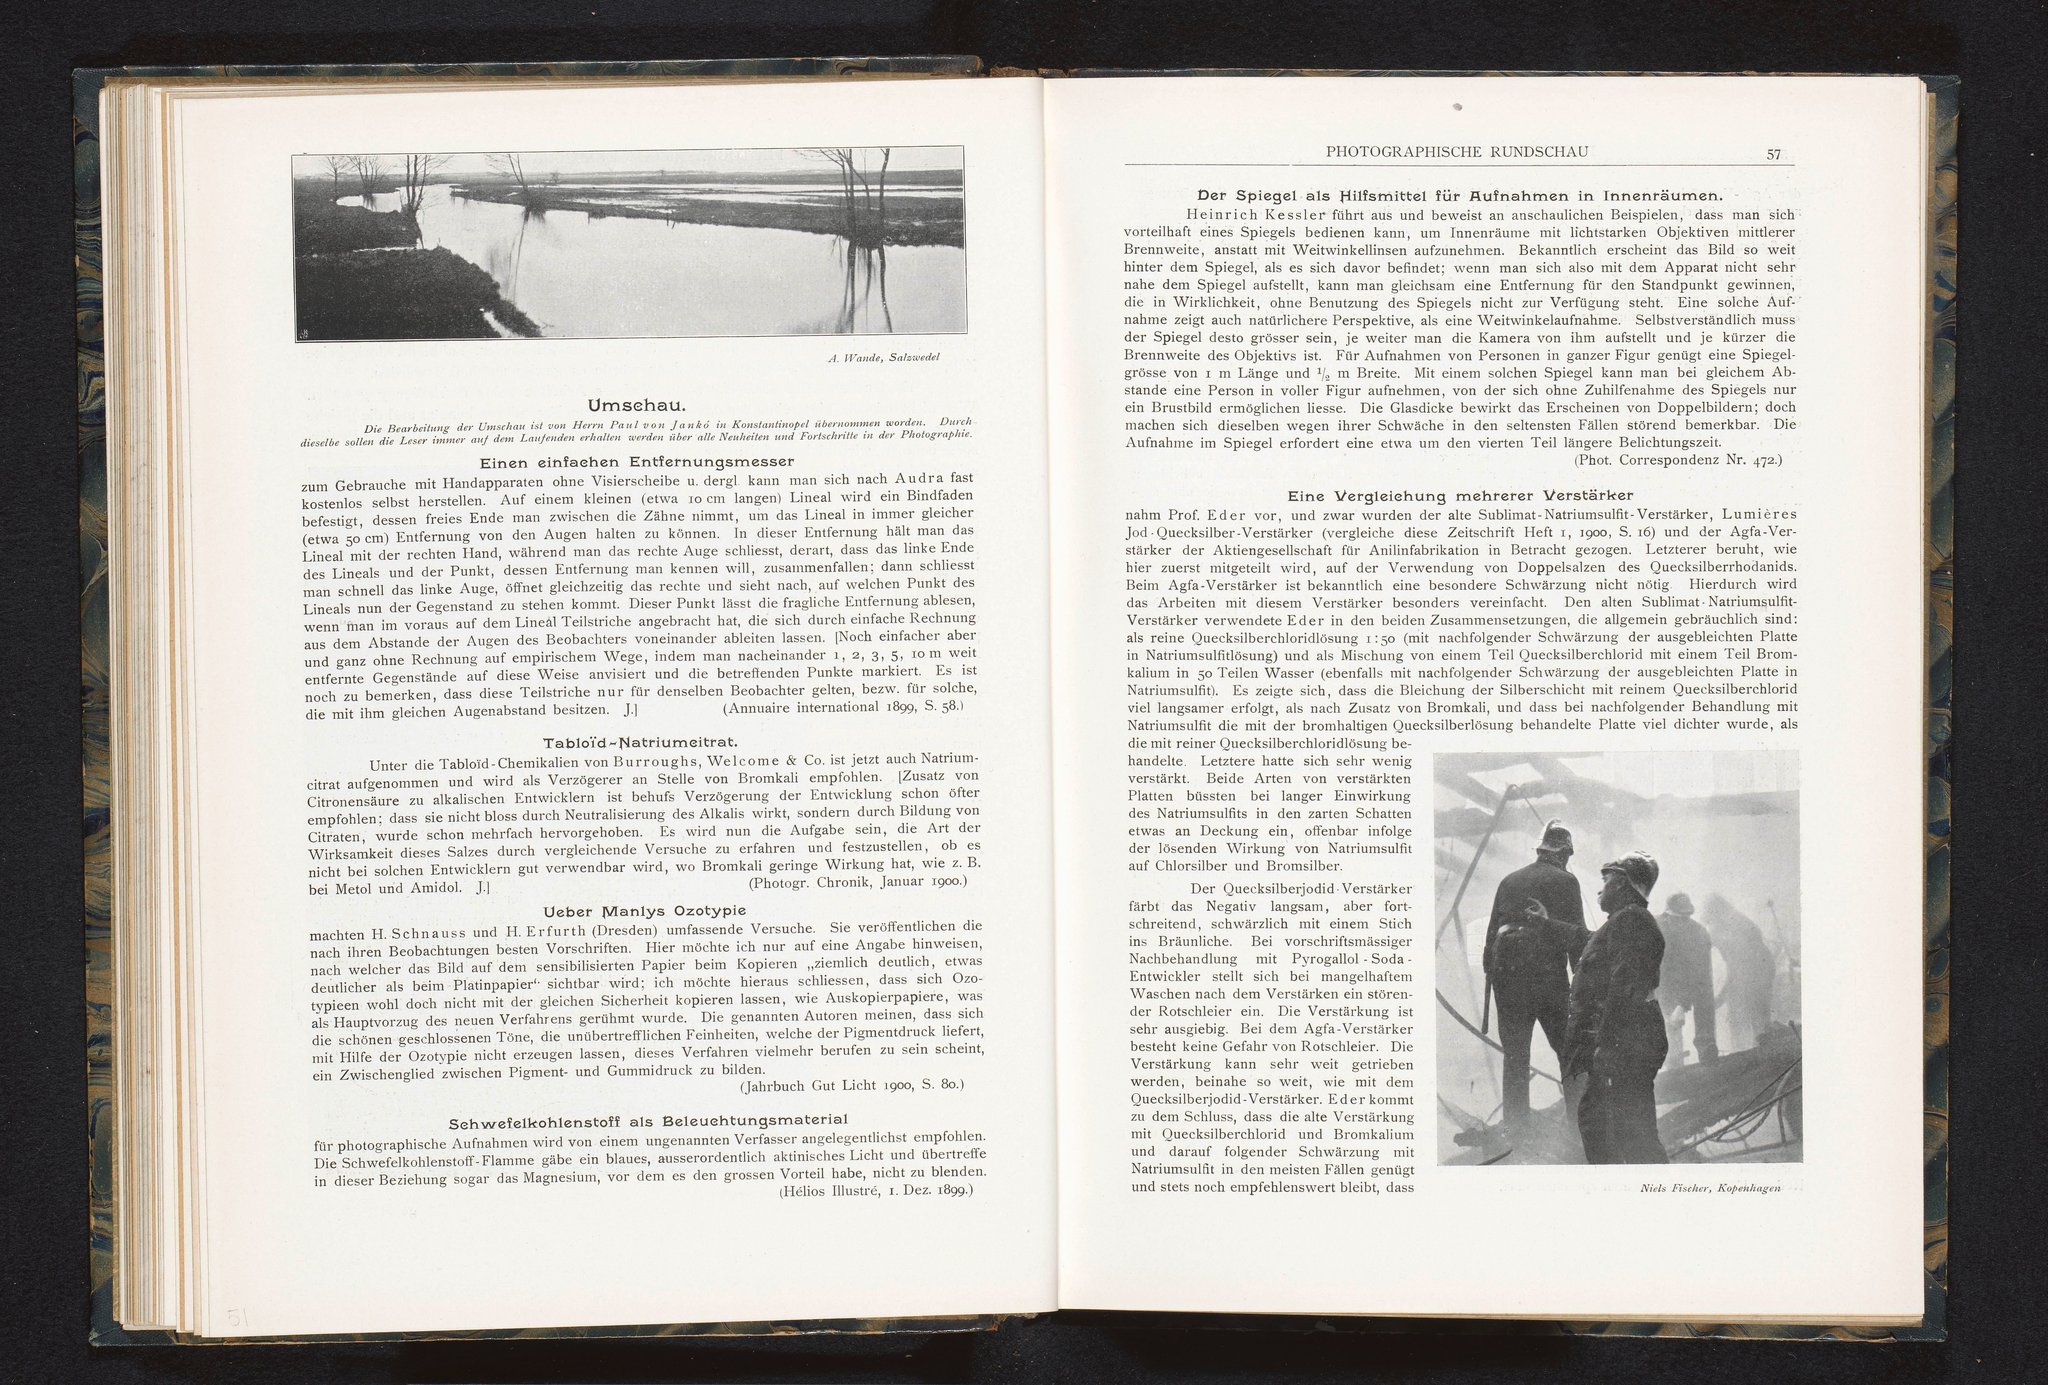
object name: photomechanical print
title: Gezicht op een sloot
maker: a. wande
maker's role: fotograaf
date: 1895-1900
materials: paper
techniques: autotype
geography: berlin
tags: small canal, ditch